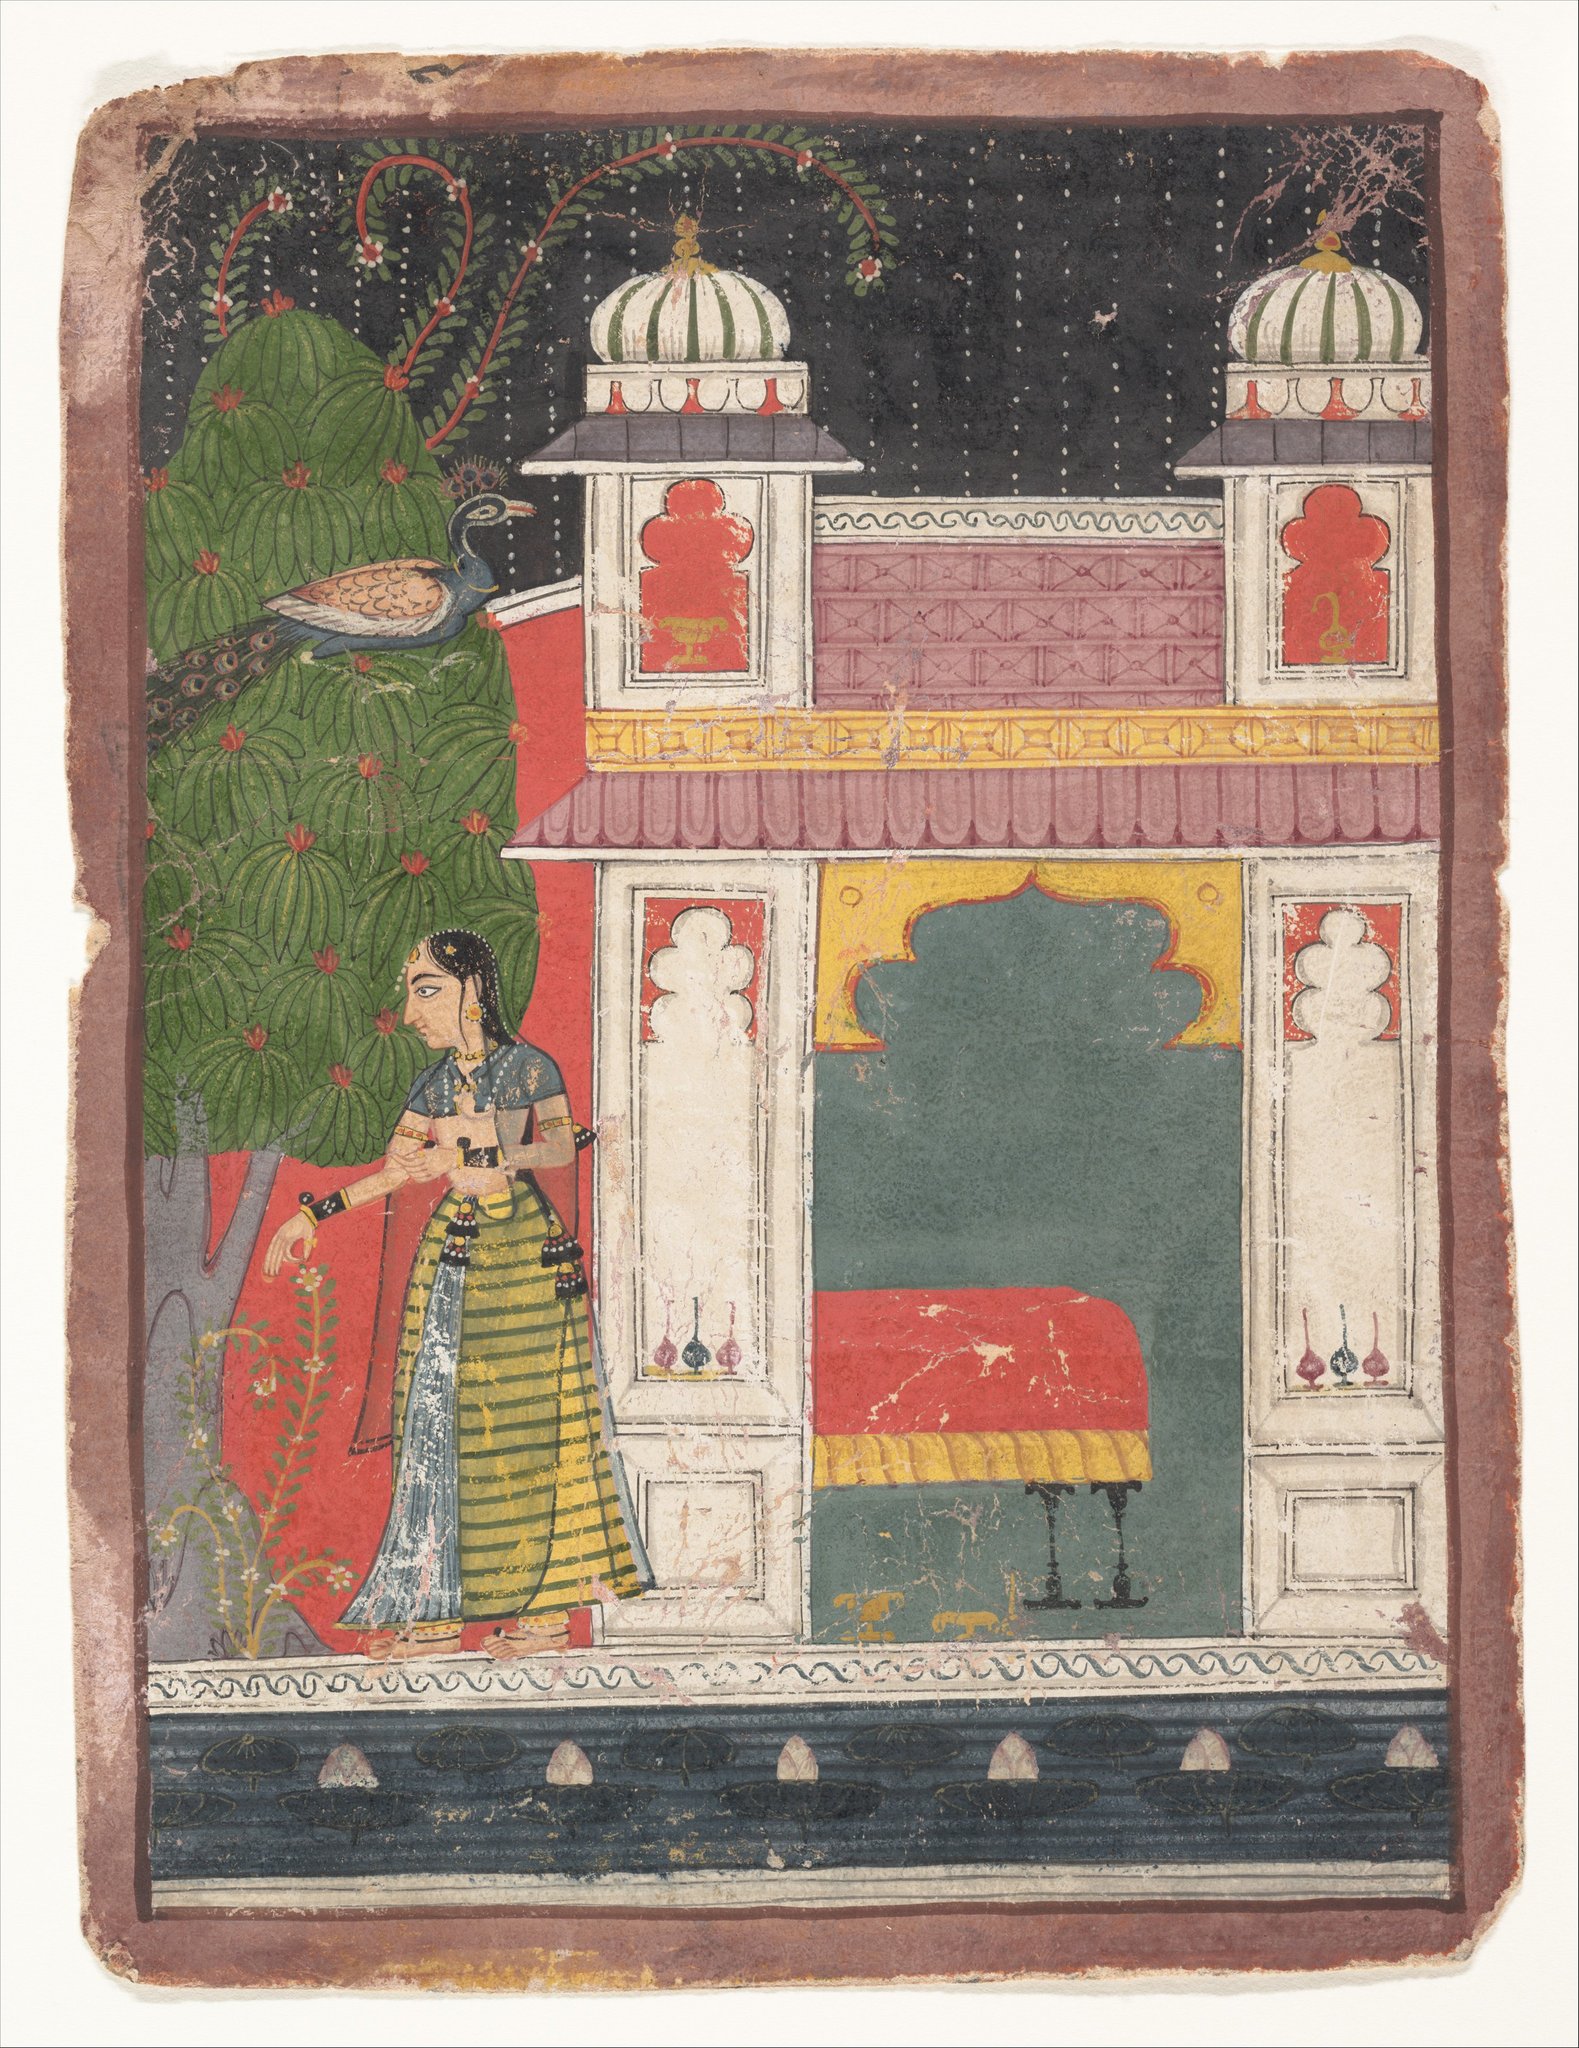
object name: folio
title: A Heroine Plucking a Flower: Page from a Dispersed Nayikabheda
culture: indian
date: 1660-1680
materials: ink, paper, watercolor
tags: women,peacocks,beds